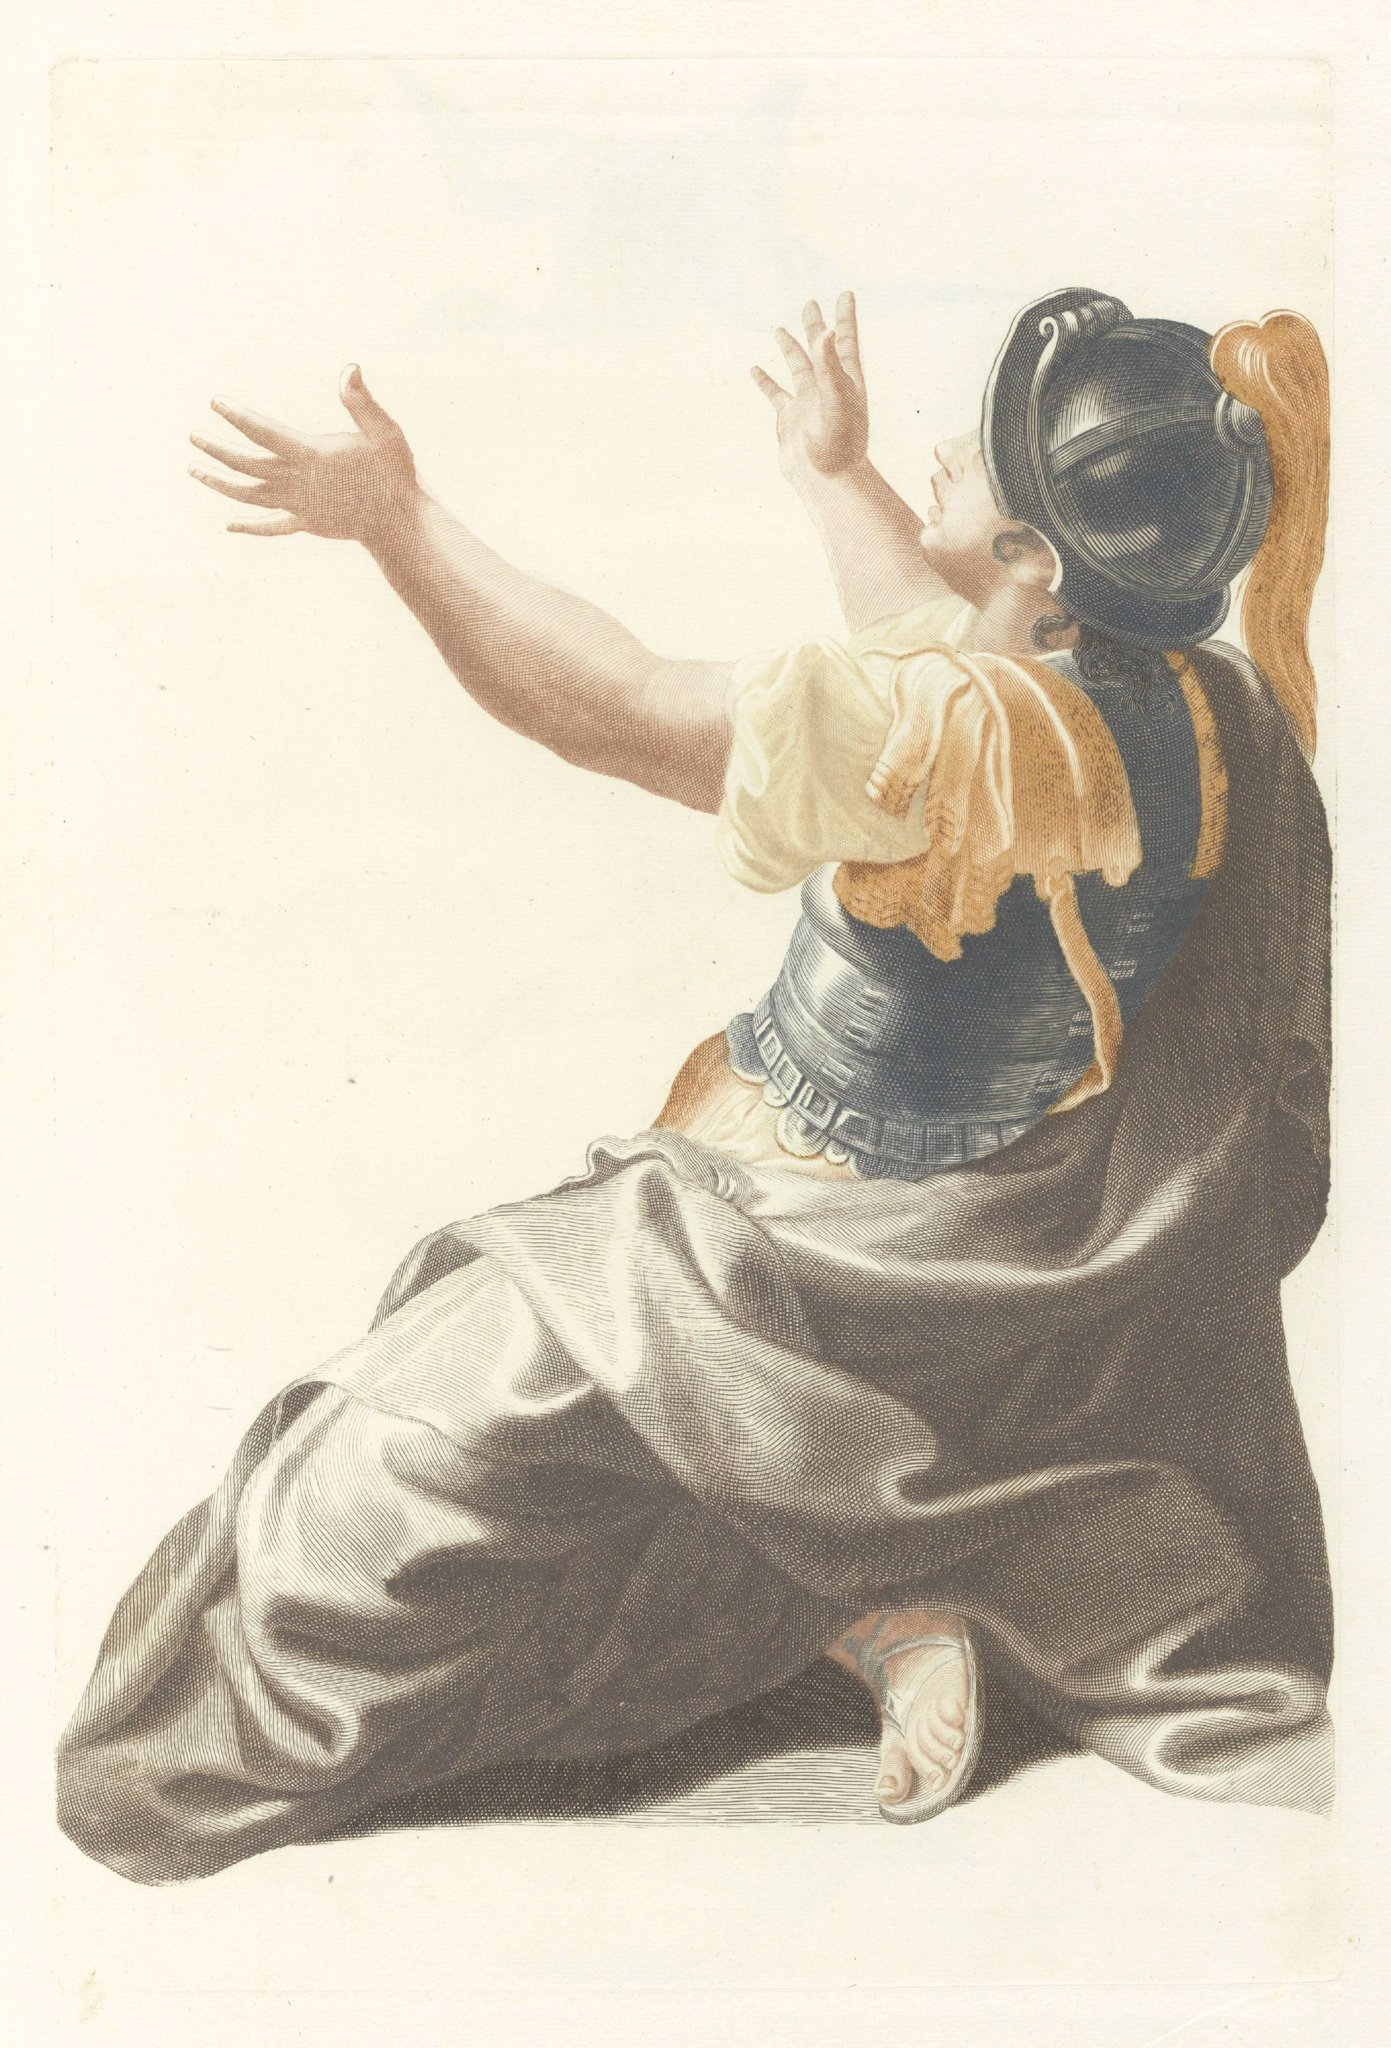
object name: album leaf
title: Gehelmde vrouwfiguur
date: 1688-1698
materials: paper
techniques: printing, engraving, lithography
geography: netherlands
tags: helmet, arm raised upward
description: Deze prent maakt deel uit van een album.